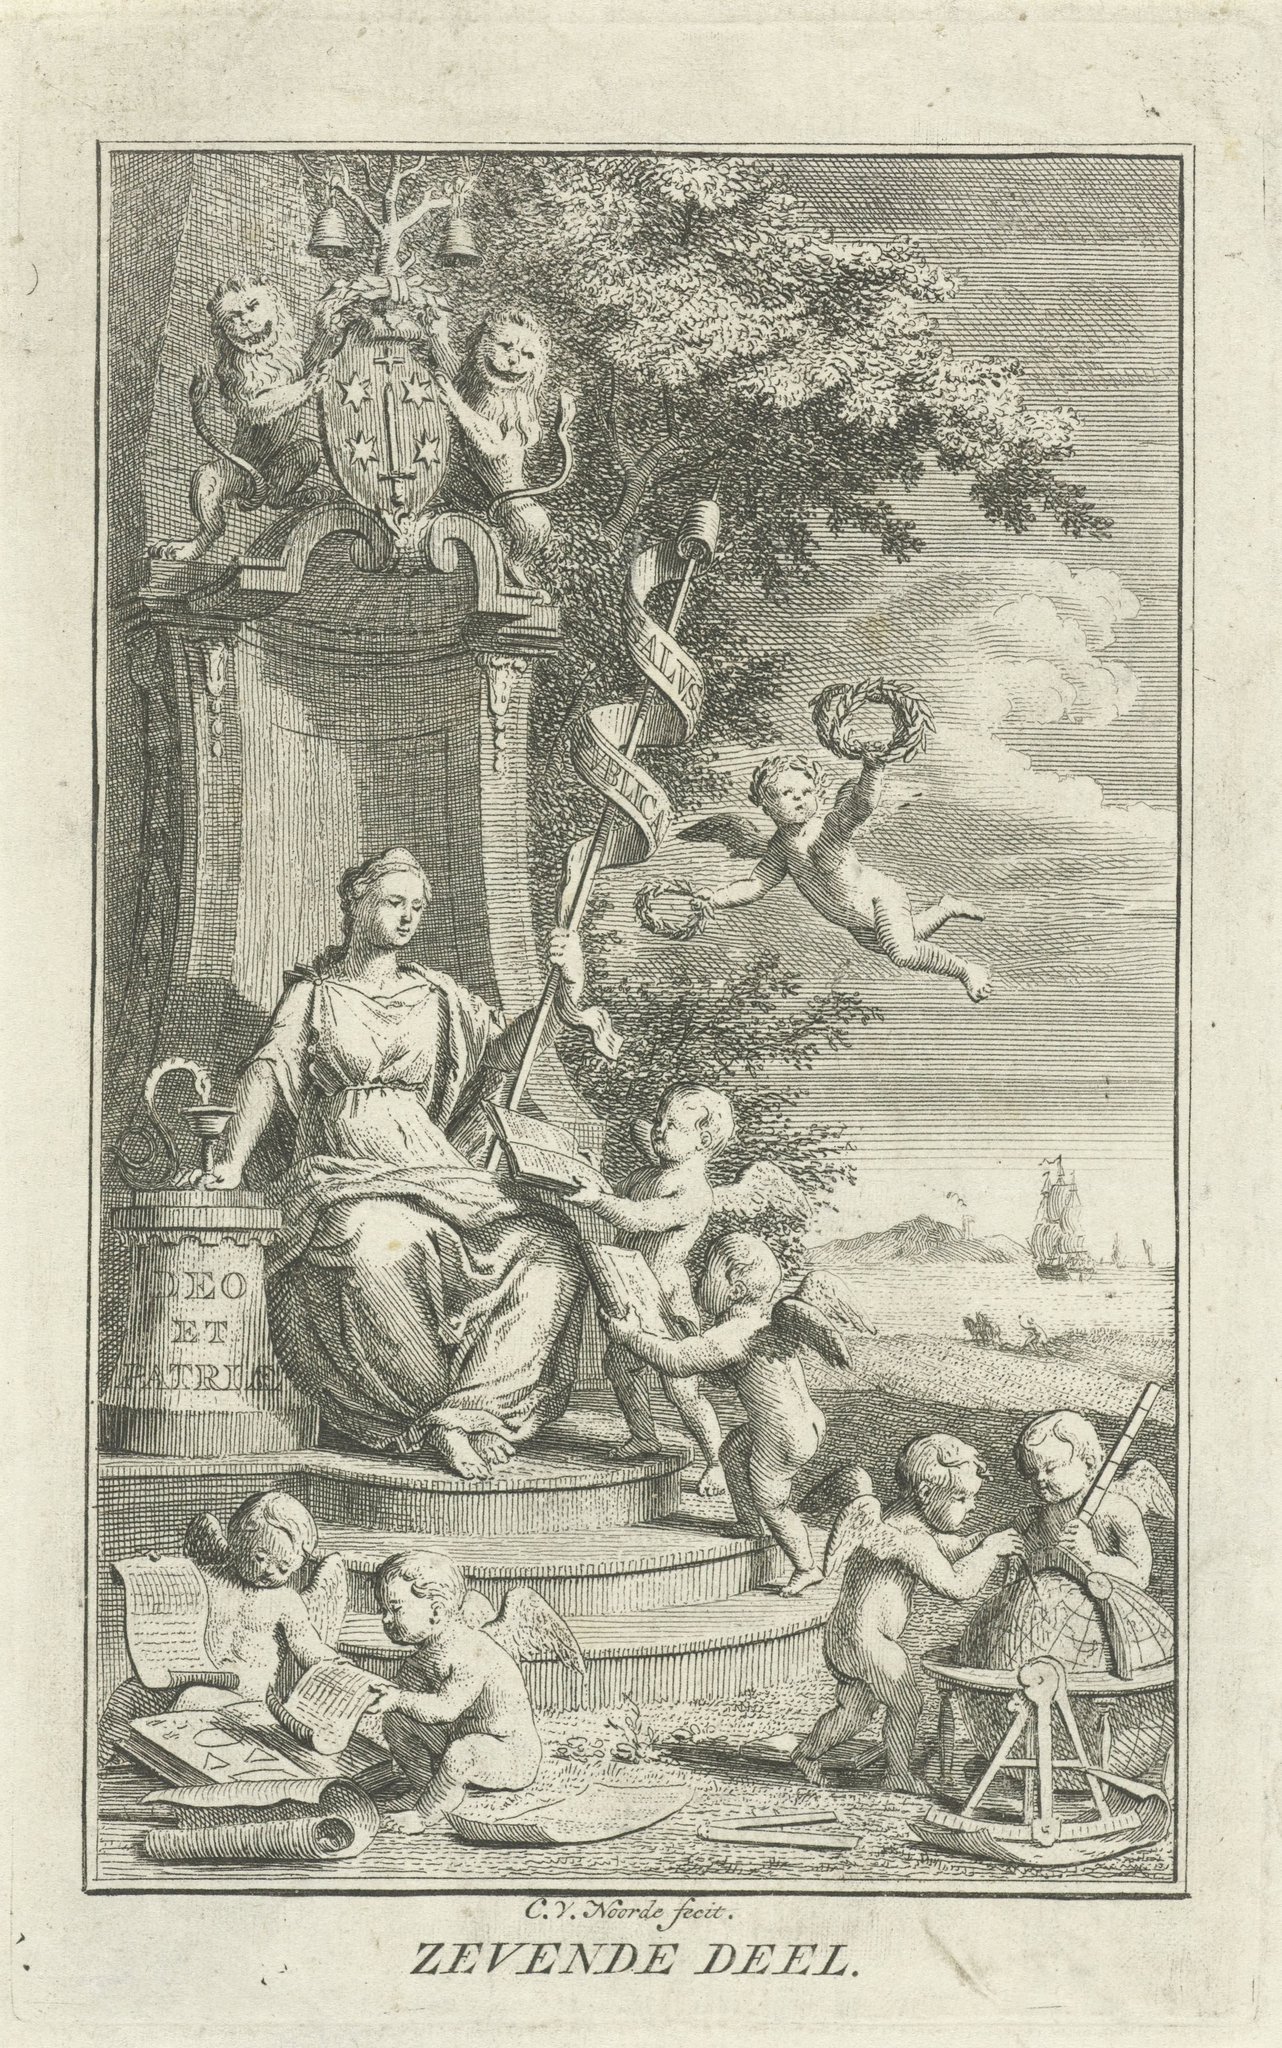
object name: print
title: Stedenmaagd van Haarlem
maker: cornelis van noorde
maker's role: draughtsman, print maker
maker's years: 1731-1795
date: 1741-1795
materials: paper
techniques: etching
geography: haarlem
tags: sailing-ship, sailing-boat, symbolic representations, allegories and emblems ~ science, 'scientia'; 'scienza', 'studio' (ripa), personification of a city, town-patron(ess), cupids: 'amores', 'amoretti', 'putti'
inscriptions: collector's mark: Lugt 2228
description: De stedenmaagd van Haarlem zit onder het wapen van Haarlem met een staf met banderol in haar handen. Op de banderol staat: Salvus Publica, algemeen welzijn. De stedenmaagd laat haar hand rusten op een piedestal met de woorden: Deo et Patriae. Voor de troon putti met papieren en boeken, passer en meetlat en een globe. Allegorische voorstelling waarin de stad Haarlem als bevorderaar van de wetenschap en de kunsten wordt voorgesteld.